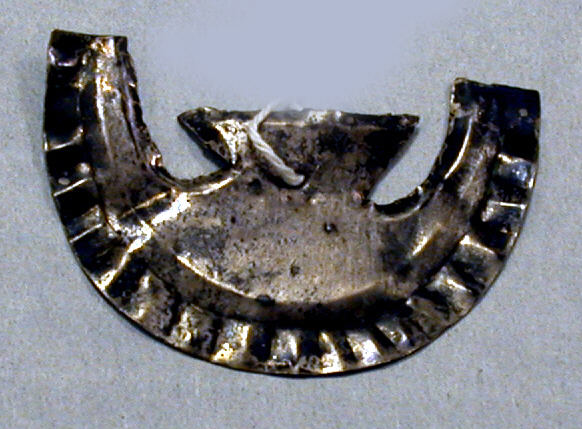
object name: ornament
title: Hammered Silver Collar Ornament (?)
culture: peruvian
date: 701-1566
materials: silver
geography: peru